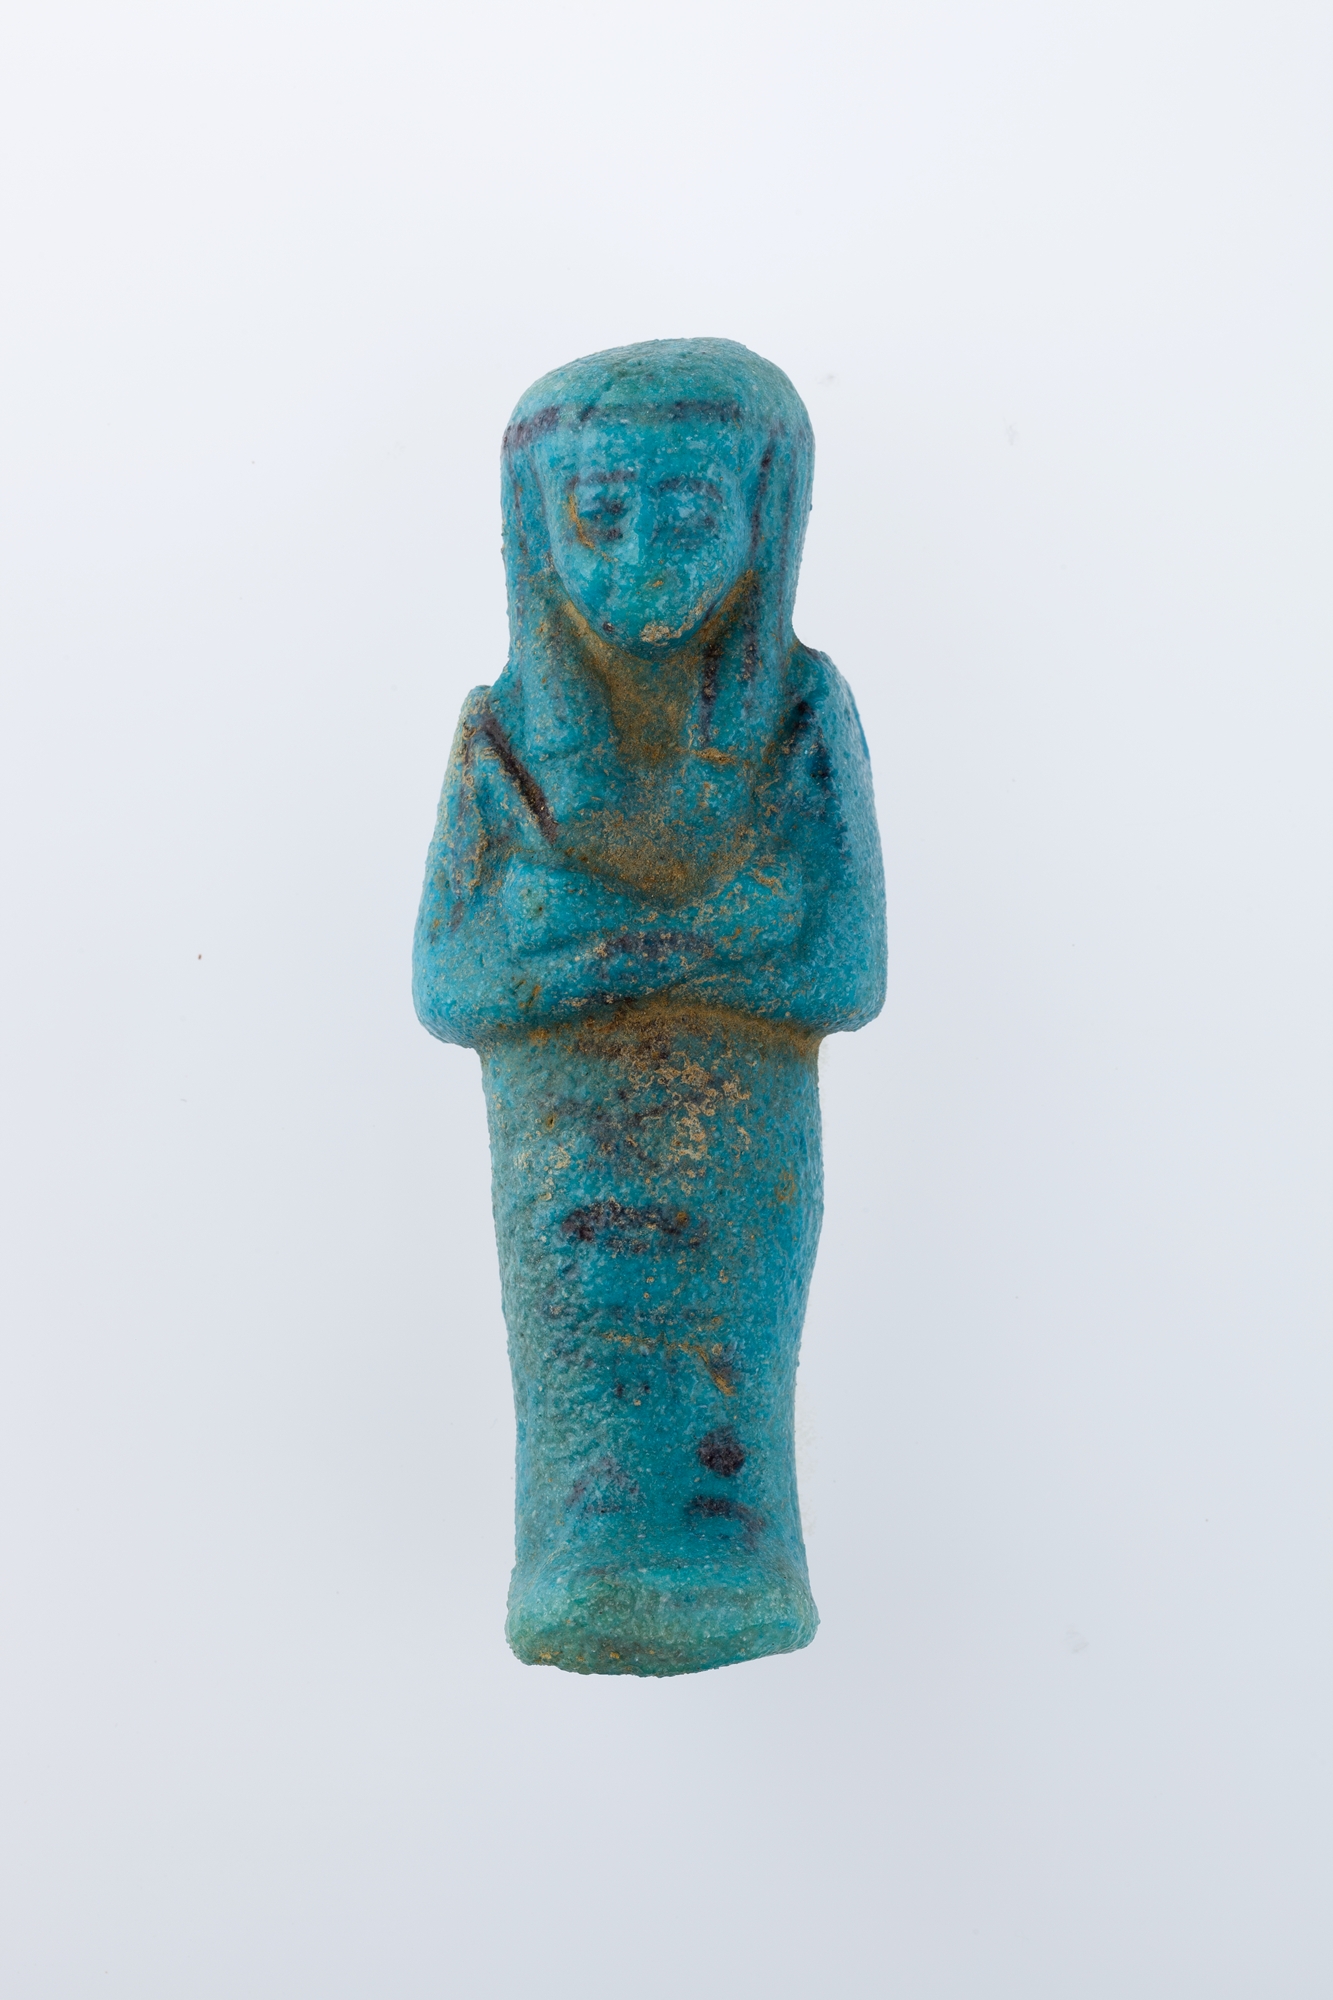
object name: shabti, henettawy c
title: Worker Shabti of Henettawy (C), Daughter of Isetemkheb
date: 990-970 BCE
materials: faience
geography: egypt